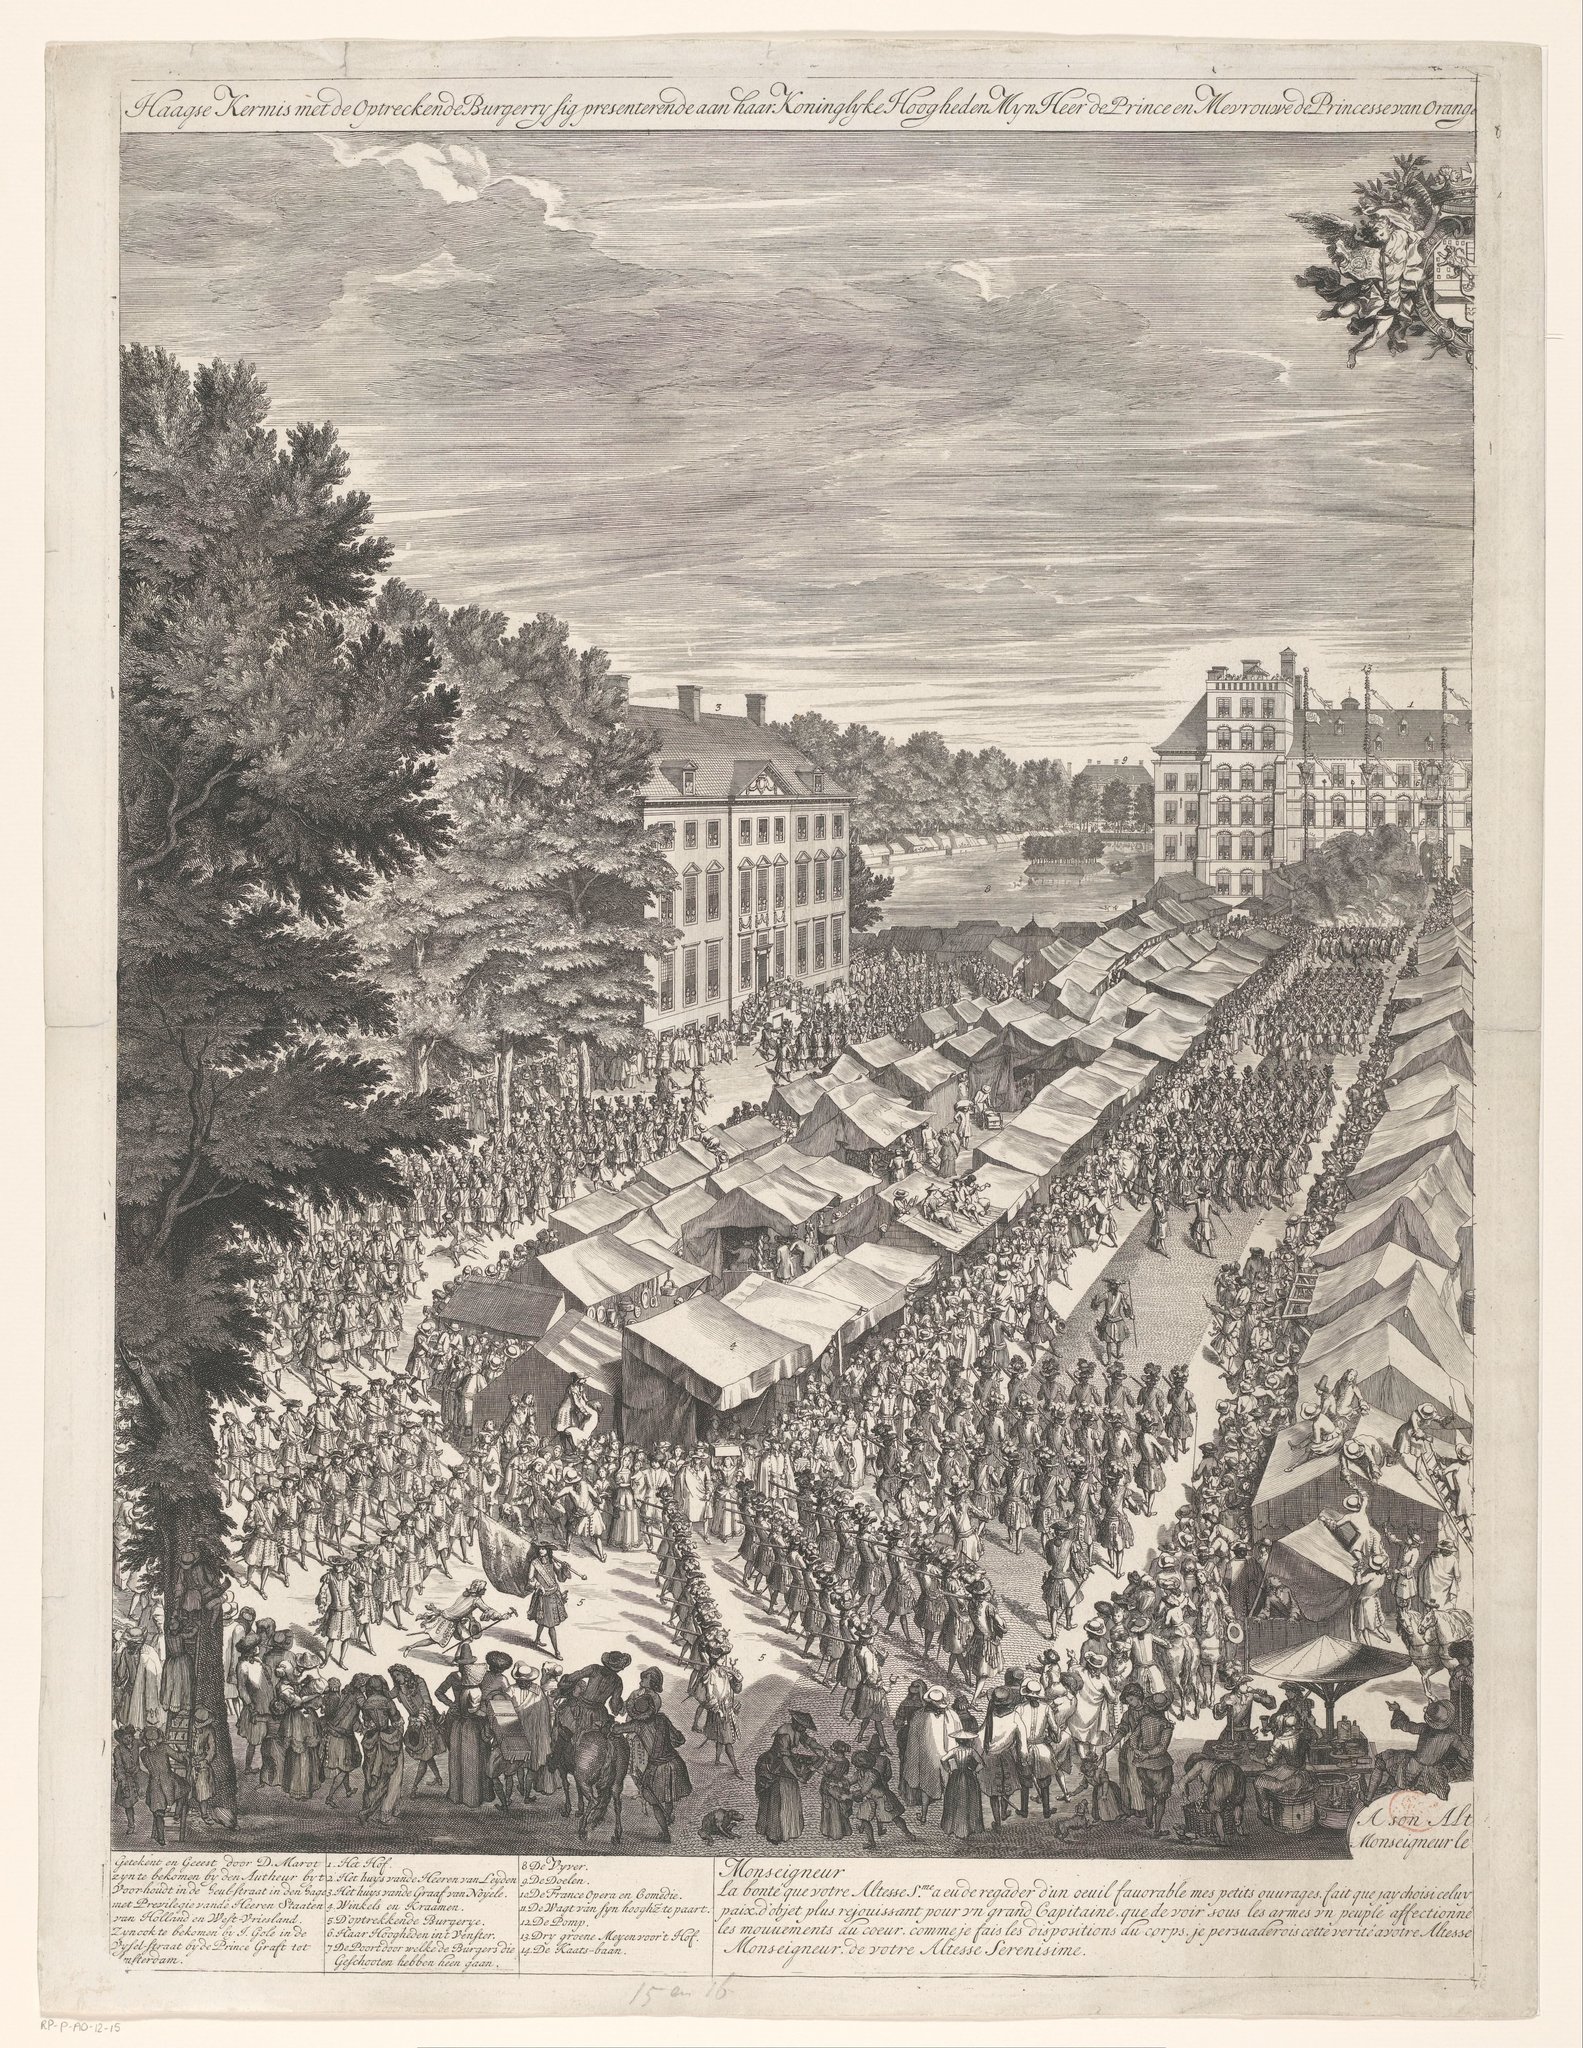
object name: print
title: Haagse Kermis met de prins en prinses van Oranje, 1686 (linkerblad)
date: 1686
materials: paper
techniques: engraving, etching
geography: the hague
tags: william iii (prince of orange and king of england, scotland, and ireland), maria ii stuart (koningin van engeland, schotland en ierland), (annual) fair, trade fair, armorial bearing, heraldry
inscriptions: collector's mark: Lugt 195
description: Linkerblad van een prent van de Haagse Kermis met de prins en prinses van Oranje, 1686.